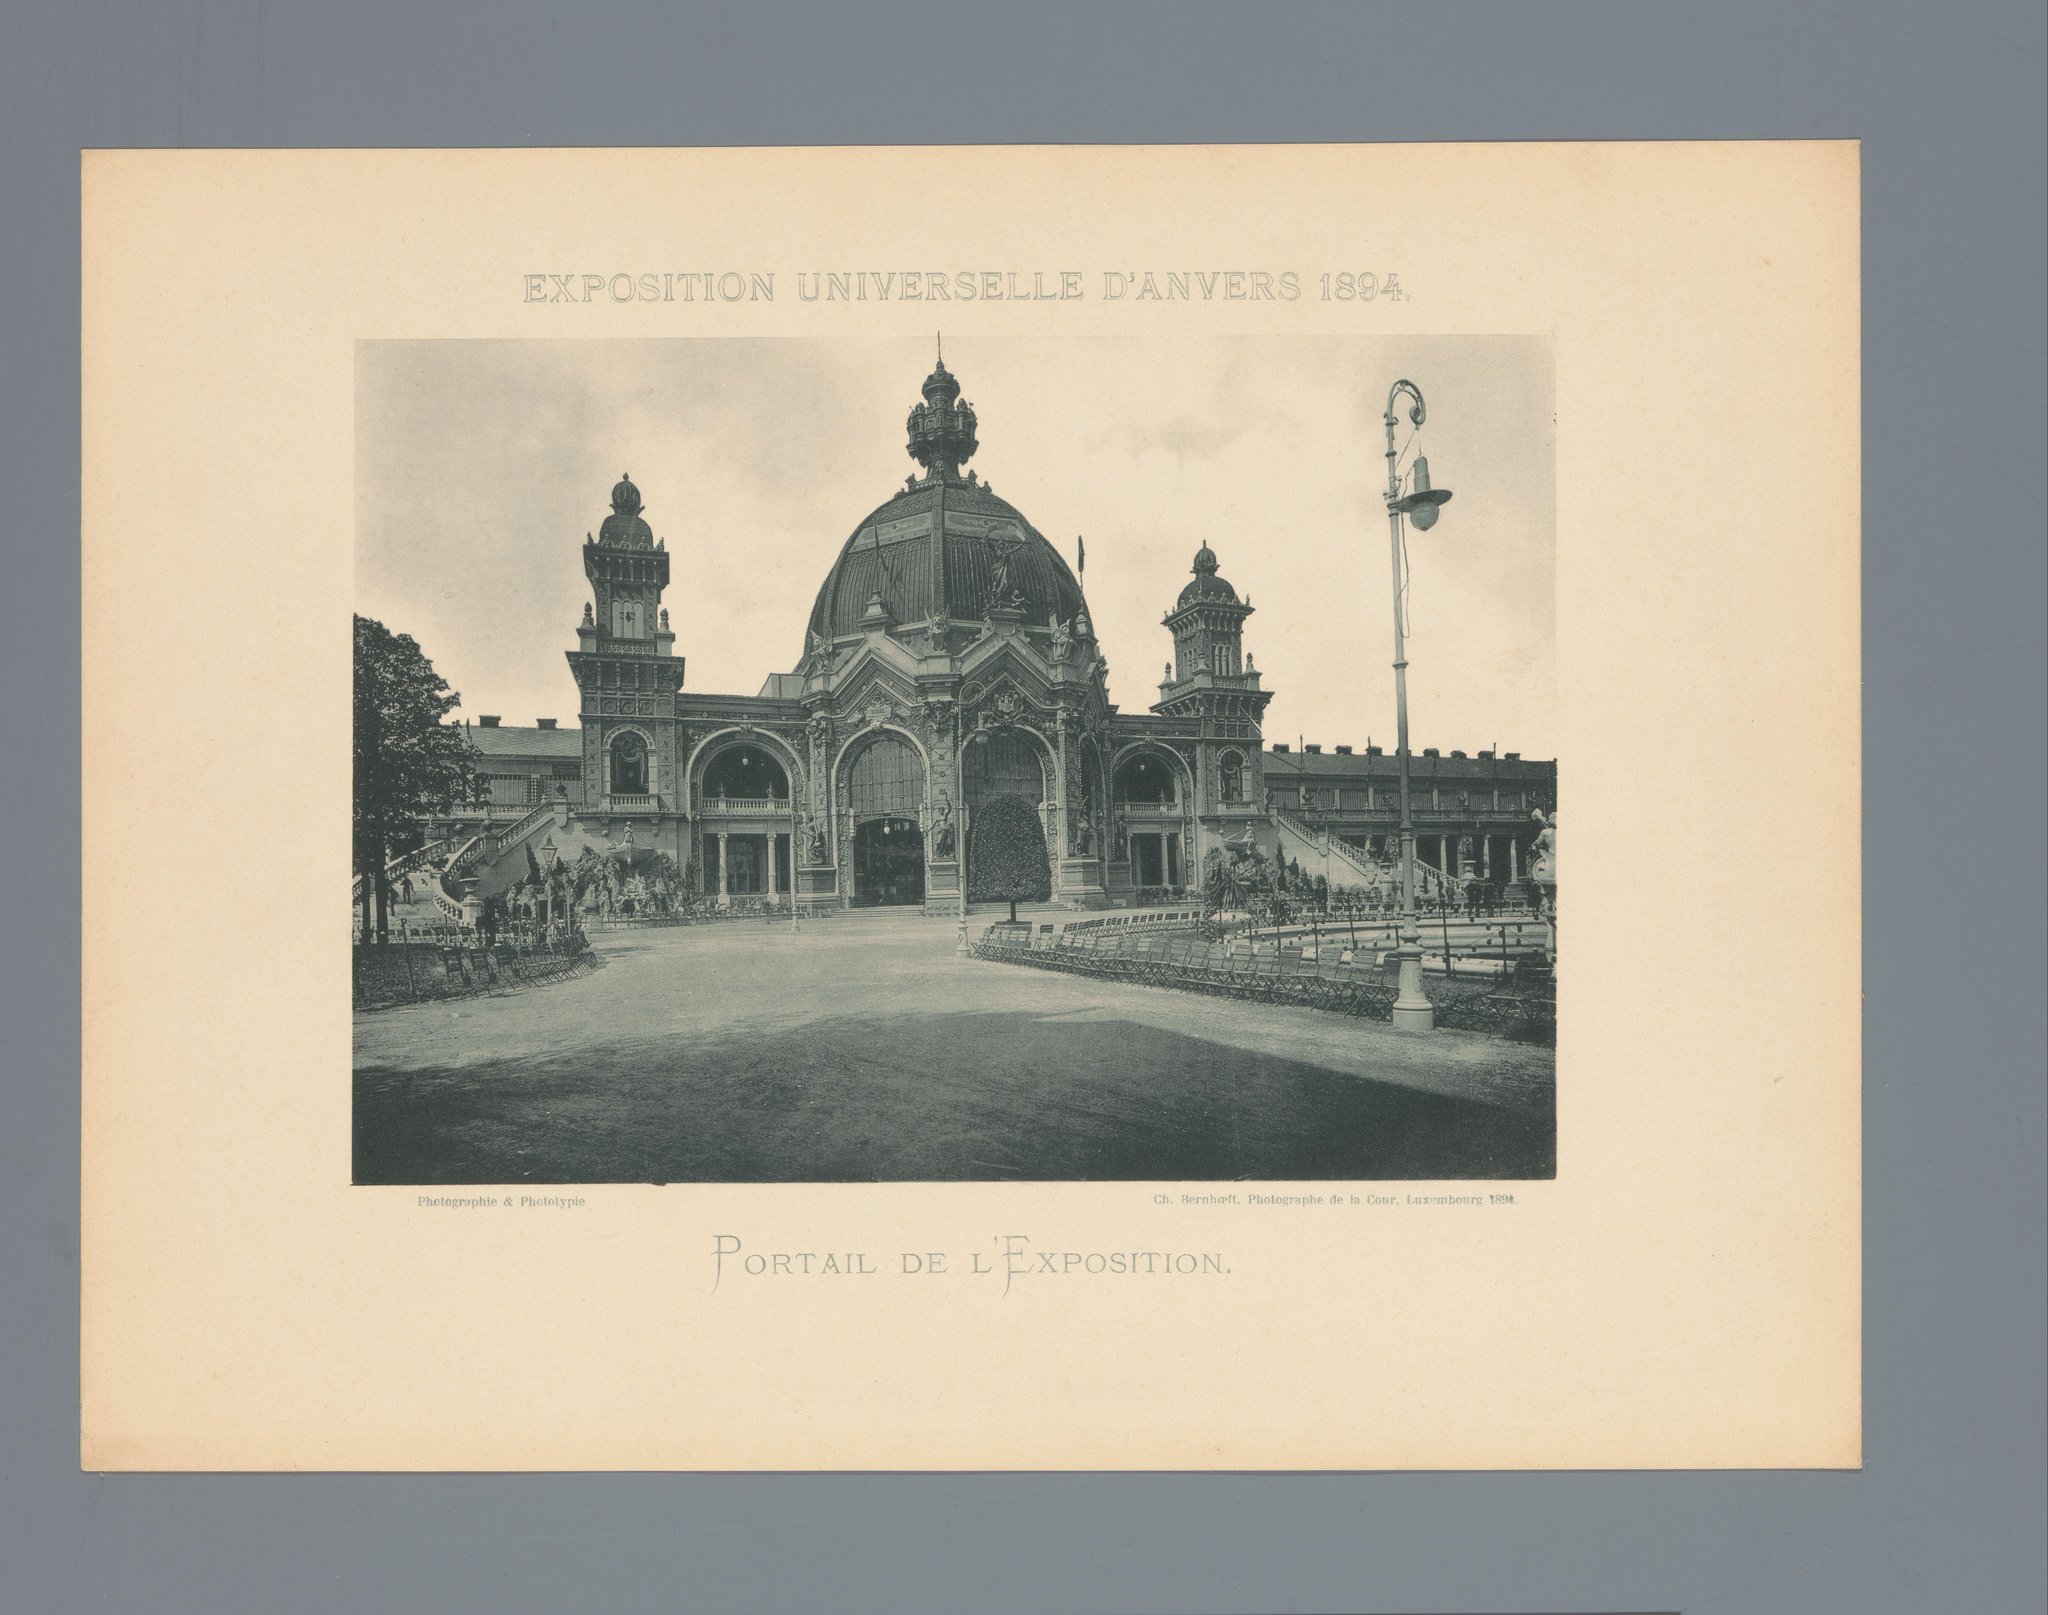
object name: photomechanical print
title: Entree van de Wereldtentoonstelling van 1894 te Antwerpen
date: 1894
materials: paper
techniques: photograph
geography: antwerp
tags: world fair, world exhibition, gate, entrance, antwerp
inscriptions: inscription: ‘Exposition Universelle D'Anvers 1894’